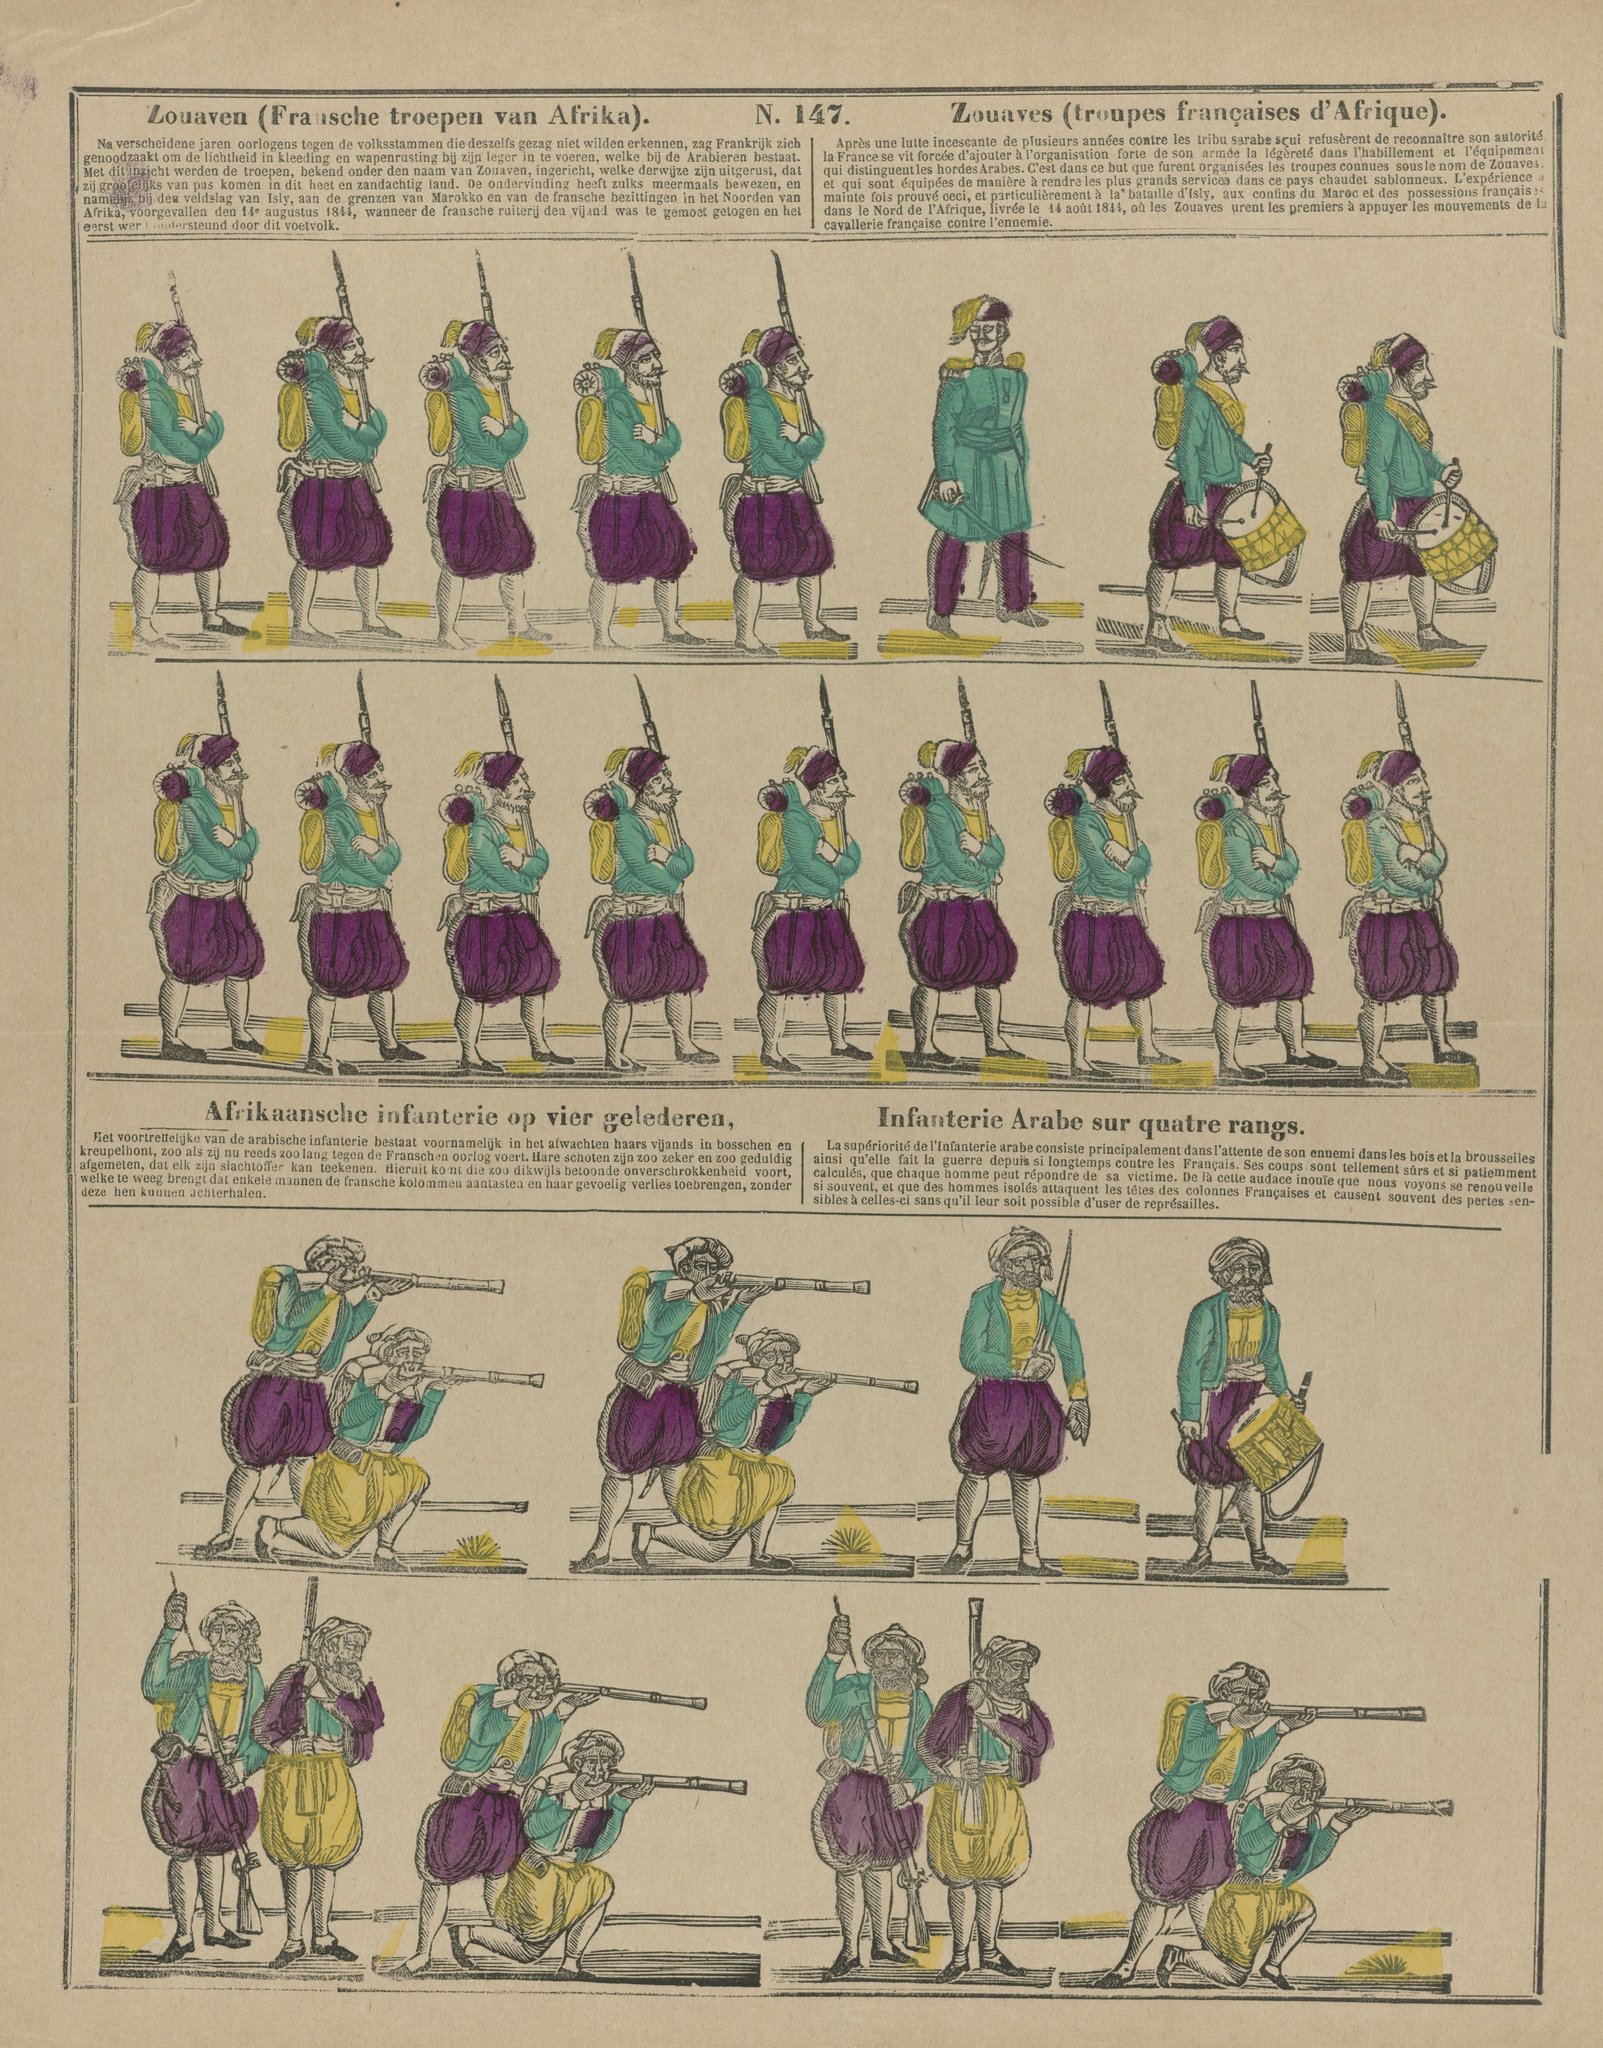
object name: popular print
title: Zouaven (Fransche troepen van Afrika) / Zouaves (troupes françaises d'Afrique) / Afrikaansche infanterie op vier gelederen / Infanterie Arabe sur quatre rangs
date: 1800-1833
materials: paper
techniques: colour, letterpress printing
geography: turnhout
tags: the soldier; the soldier's life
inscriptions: collector's mark: Lugt 2760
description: Blad met 4 horizontale rijen met voorstellingen van Franse troepen in Afrika en Afrikaanse infanterie. Onder de titels een onderschrift in het Nederlands en in het Frans in twee kolommen. Genummerd midden boven: N. 147.